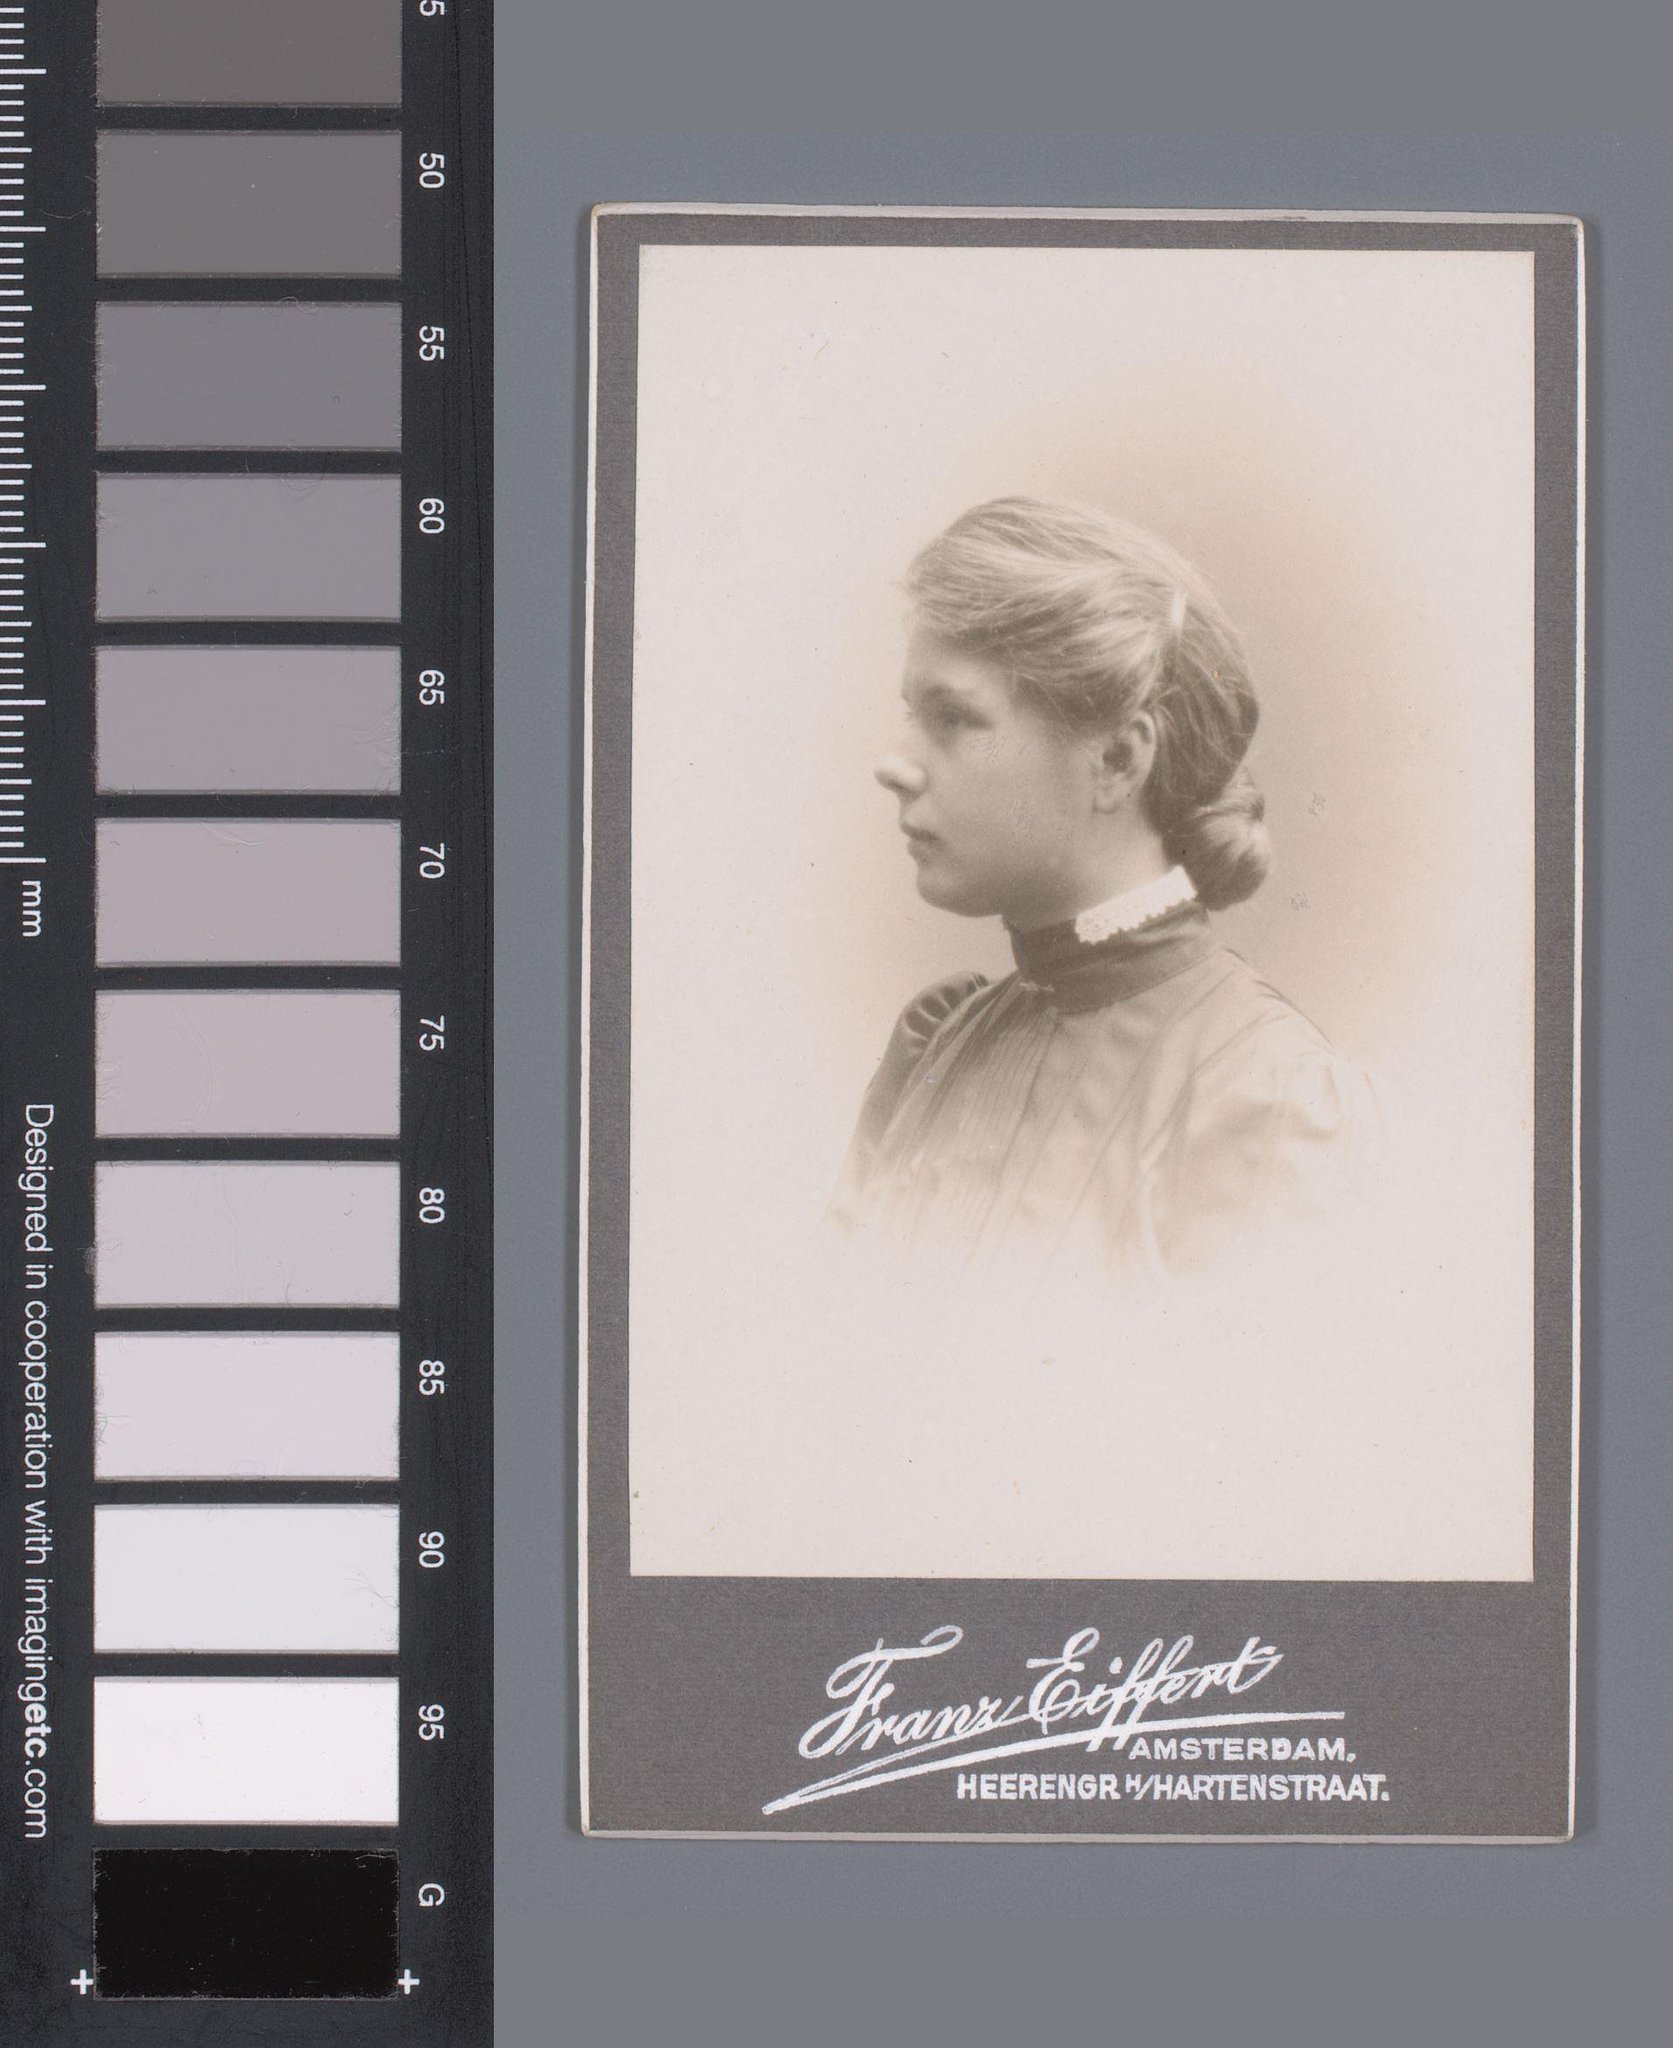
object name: carte de visite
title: Portret van een onbekende vrouw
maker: franz eiffert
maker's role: fotograaf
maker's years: 1866-1929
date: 1892-1911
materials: cardboard, photographic support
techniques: gelatin silver print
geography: amsterdam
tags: historical persons - bb - woman, amsterdam